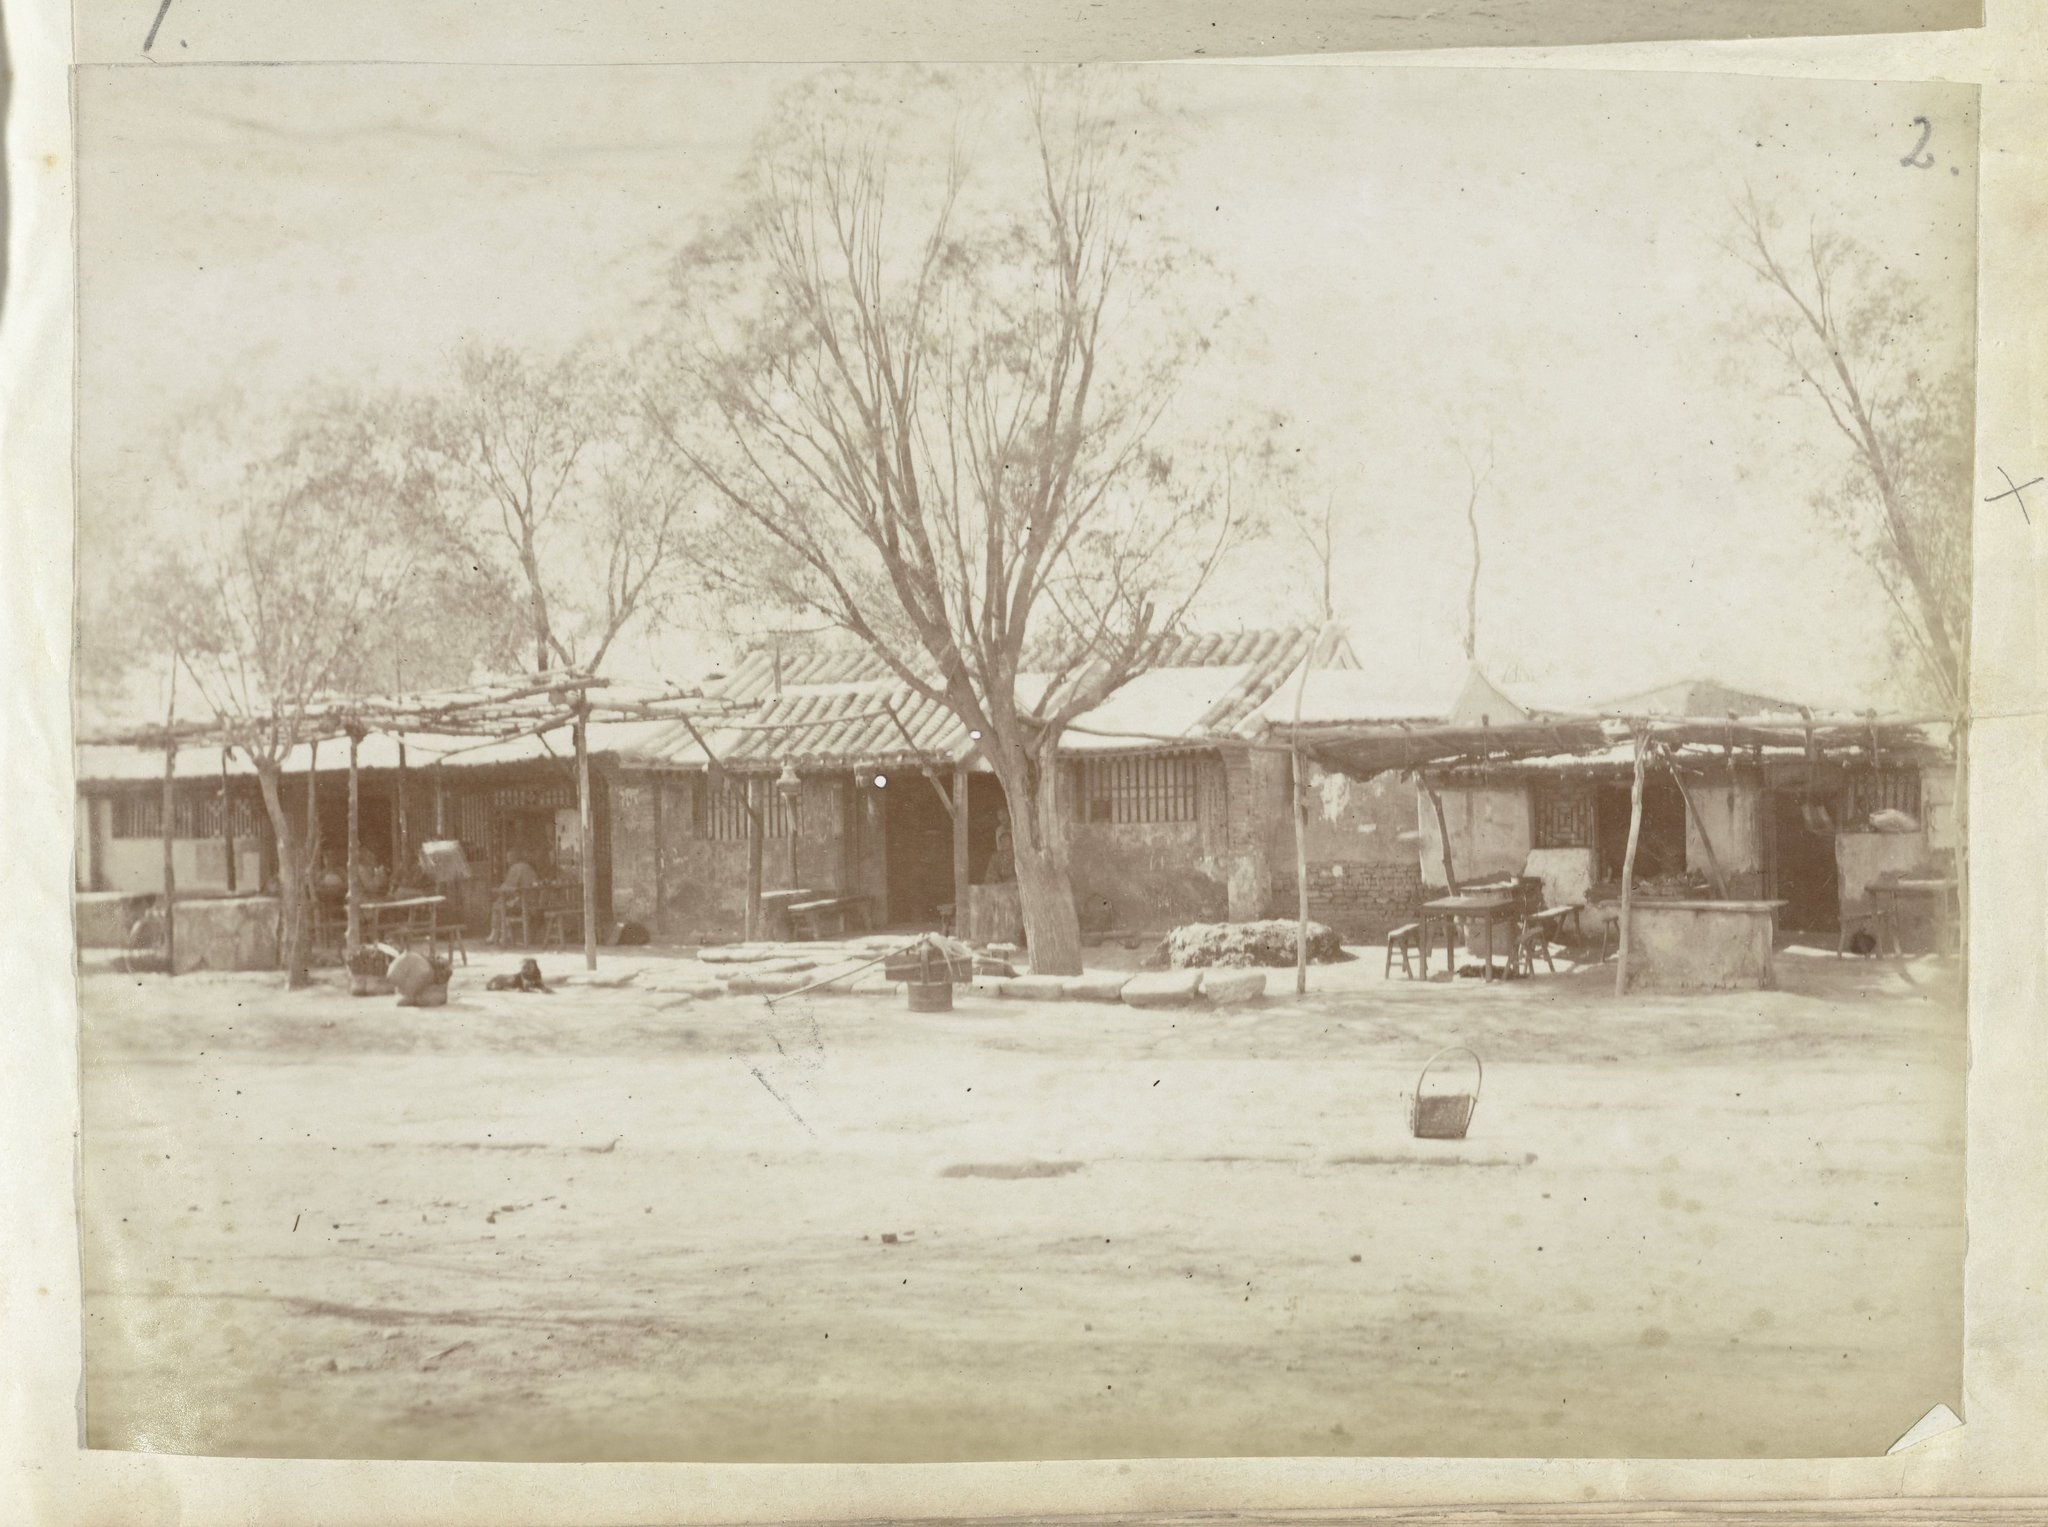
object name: photograph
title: Straatgezicht met stallen en huizen, China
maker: Anonymous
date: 1879-1890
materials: paper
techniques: albumen print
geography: china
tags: stall, stable, street, china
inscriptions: number: ‘2.’